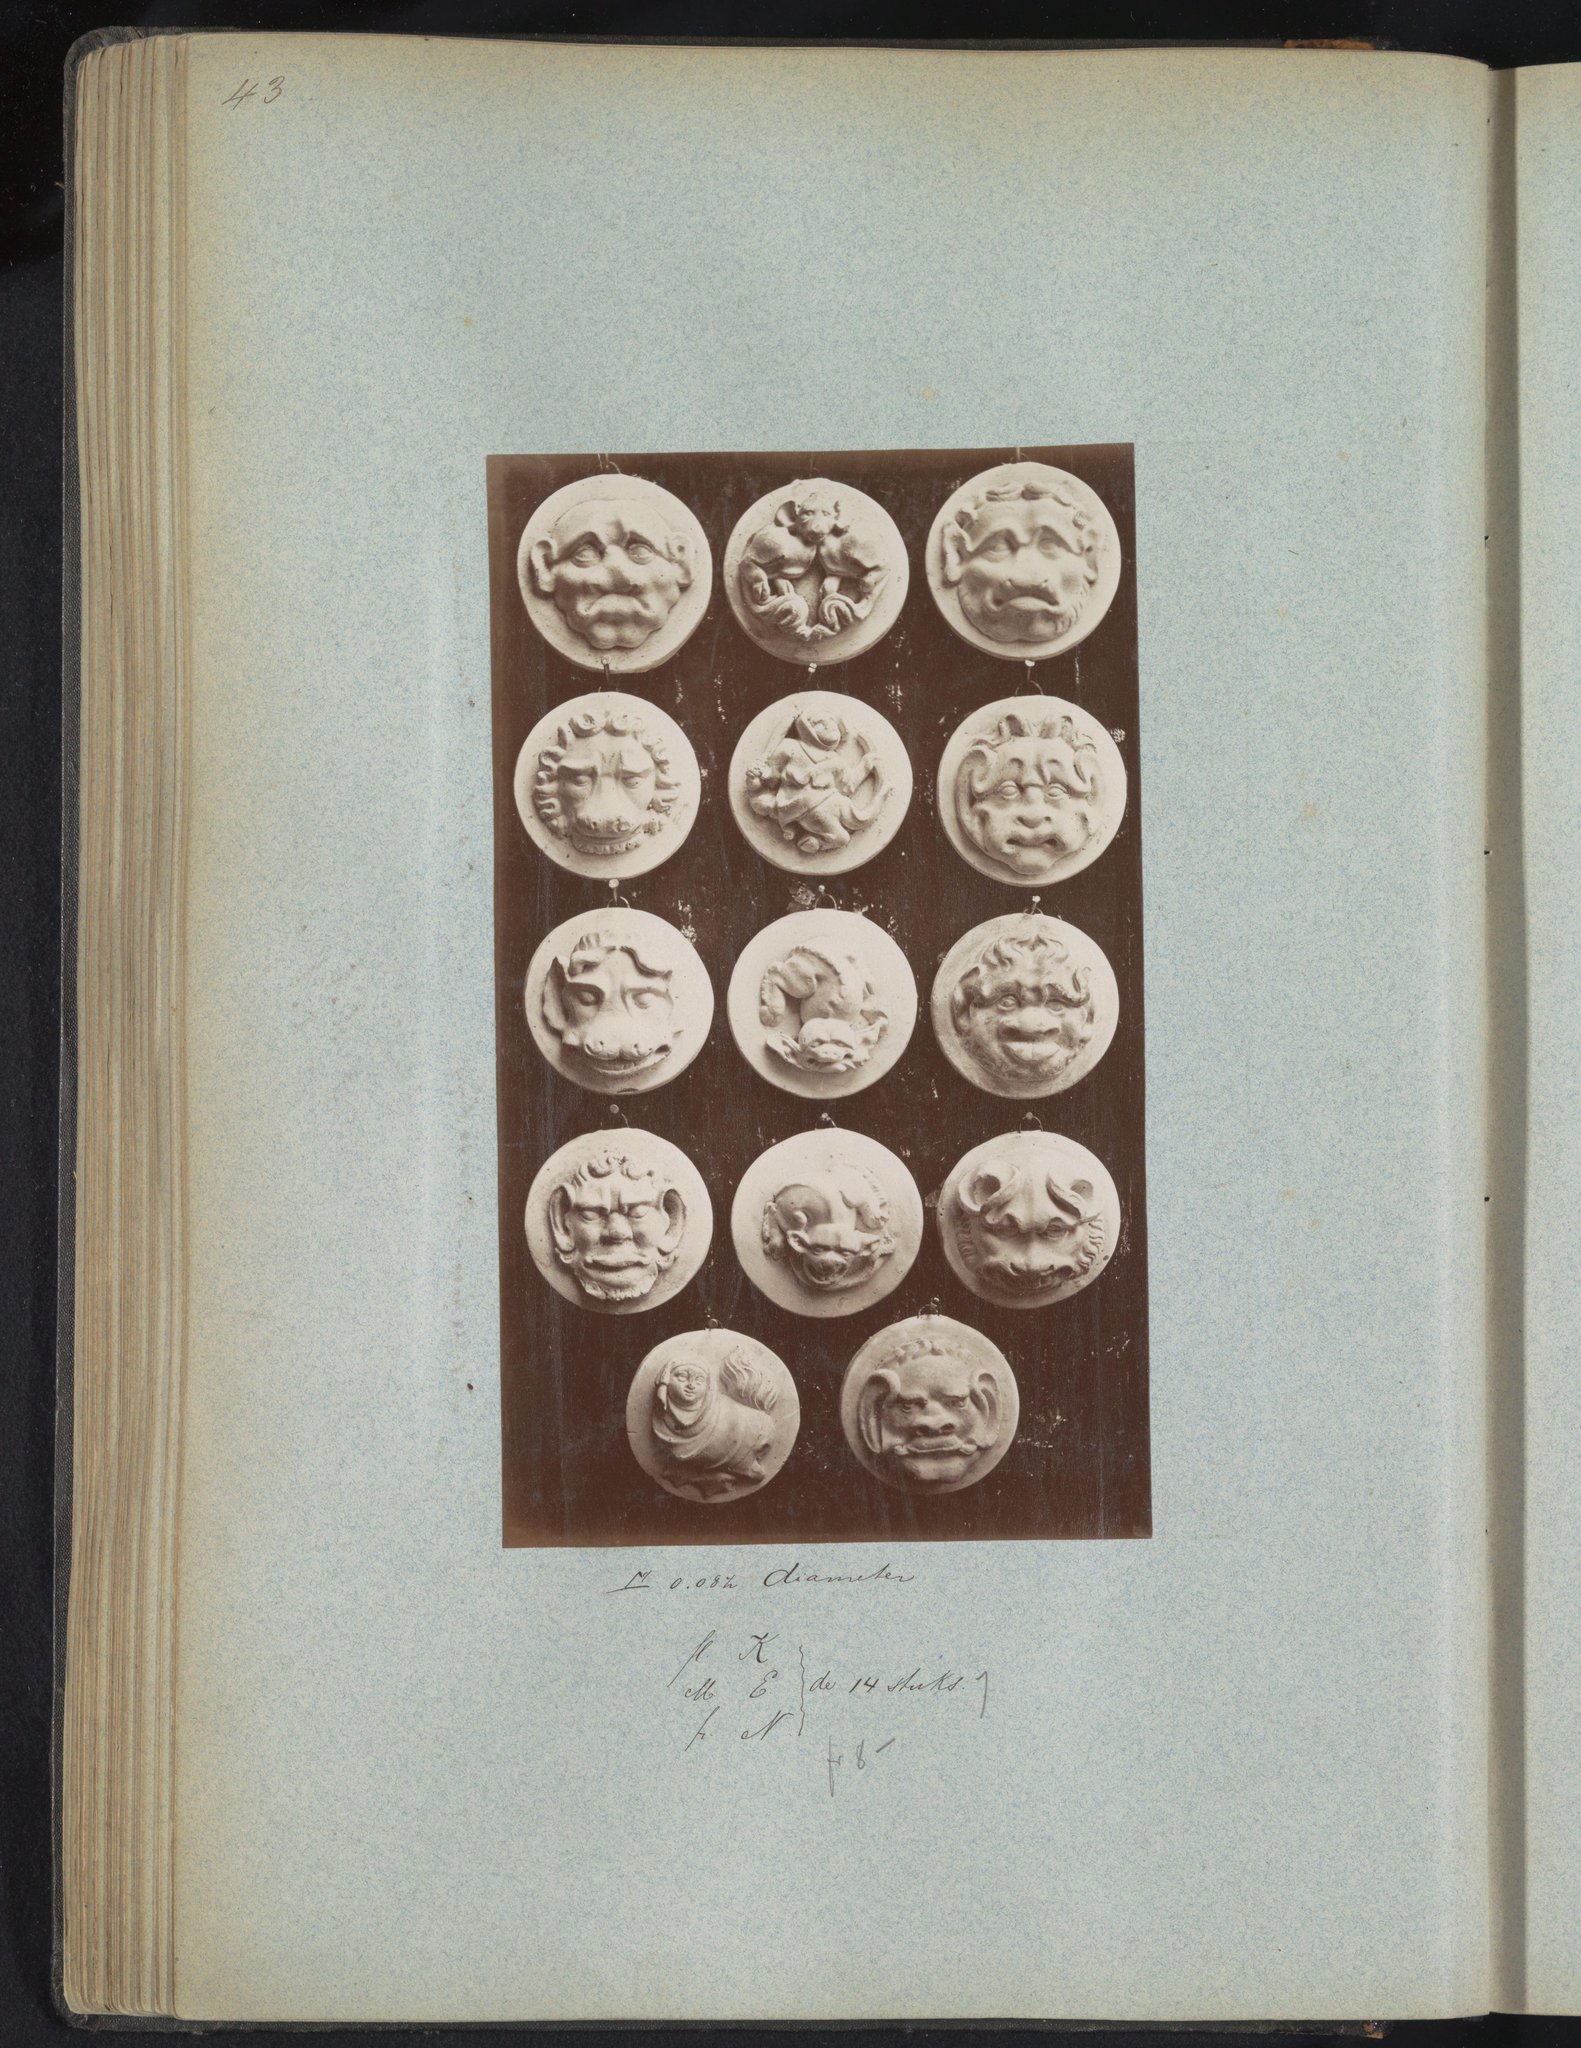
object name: album leaf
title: Veertien gipsen koppen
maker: Anonymous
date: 1875-1900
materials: paper, photographic support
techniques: albumen print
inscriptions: annotation, annotation: ‘M 0.8 1/2 diameter’